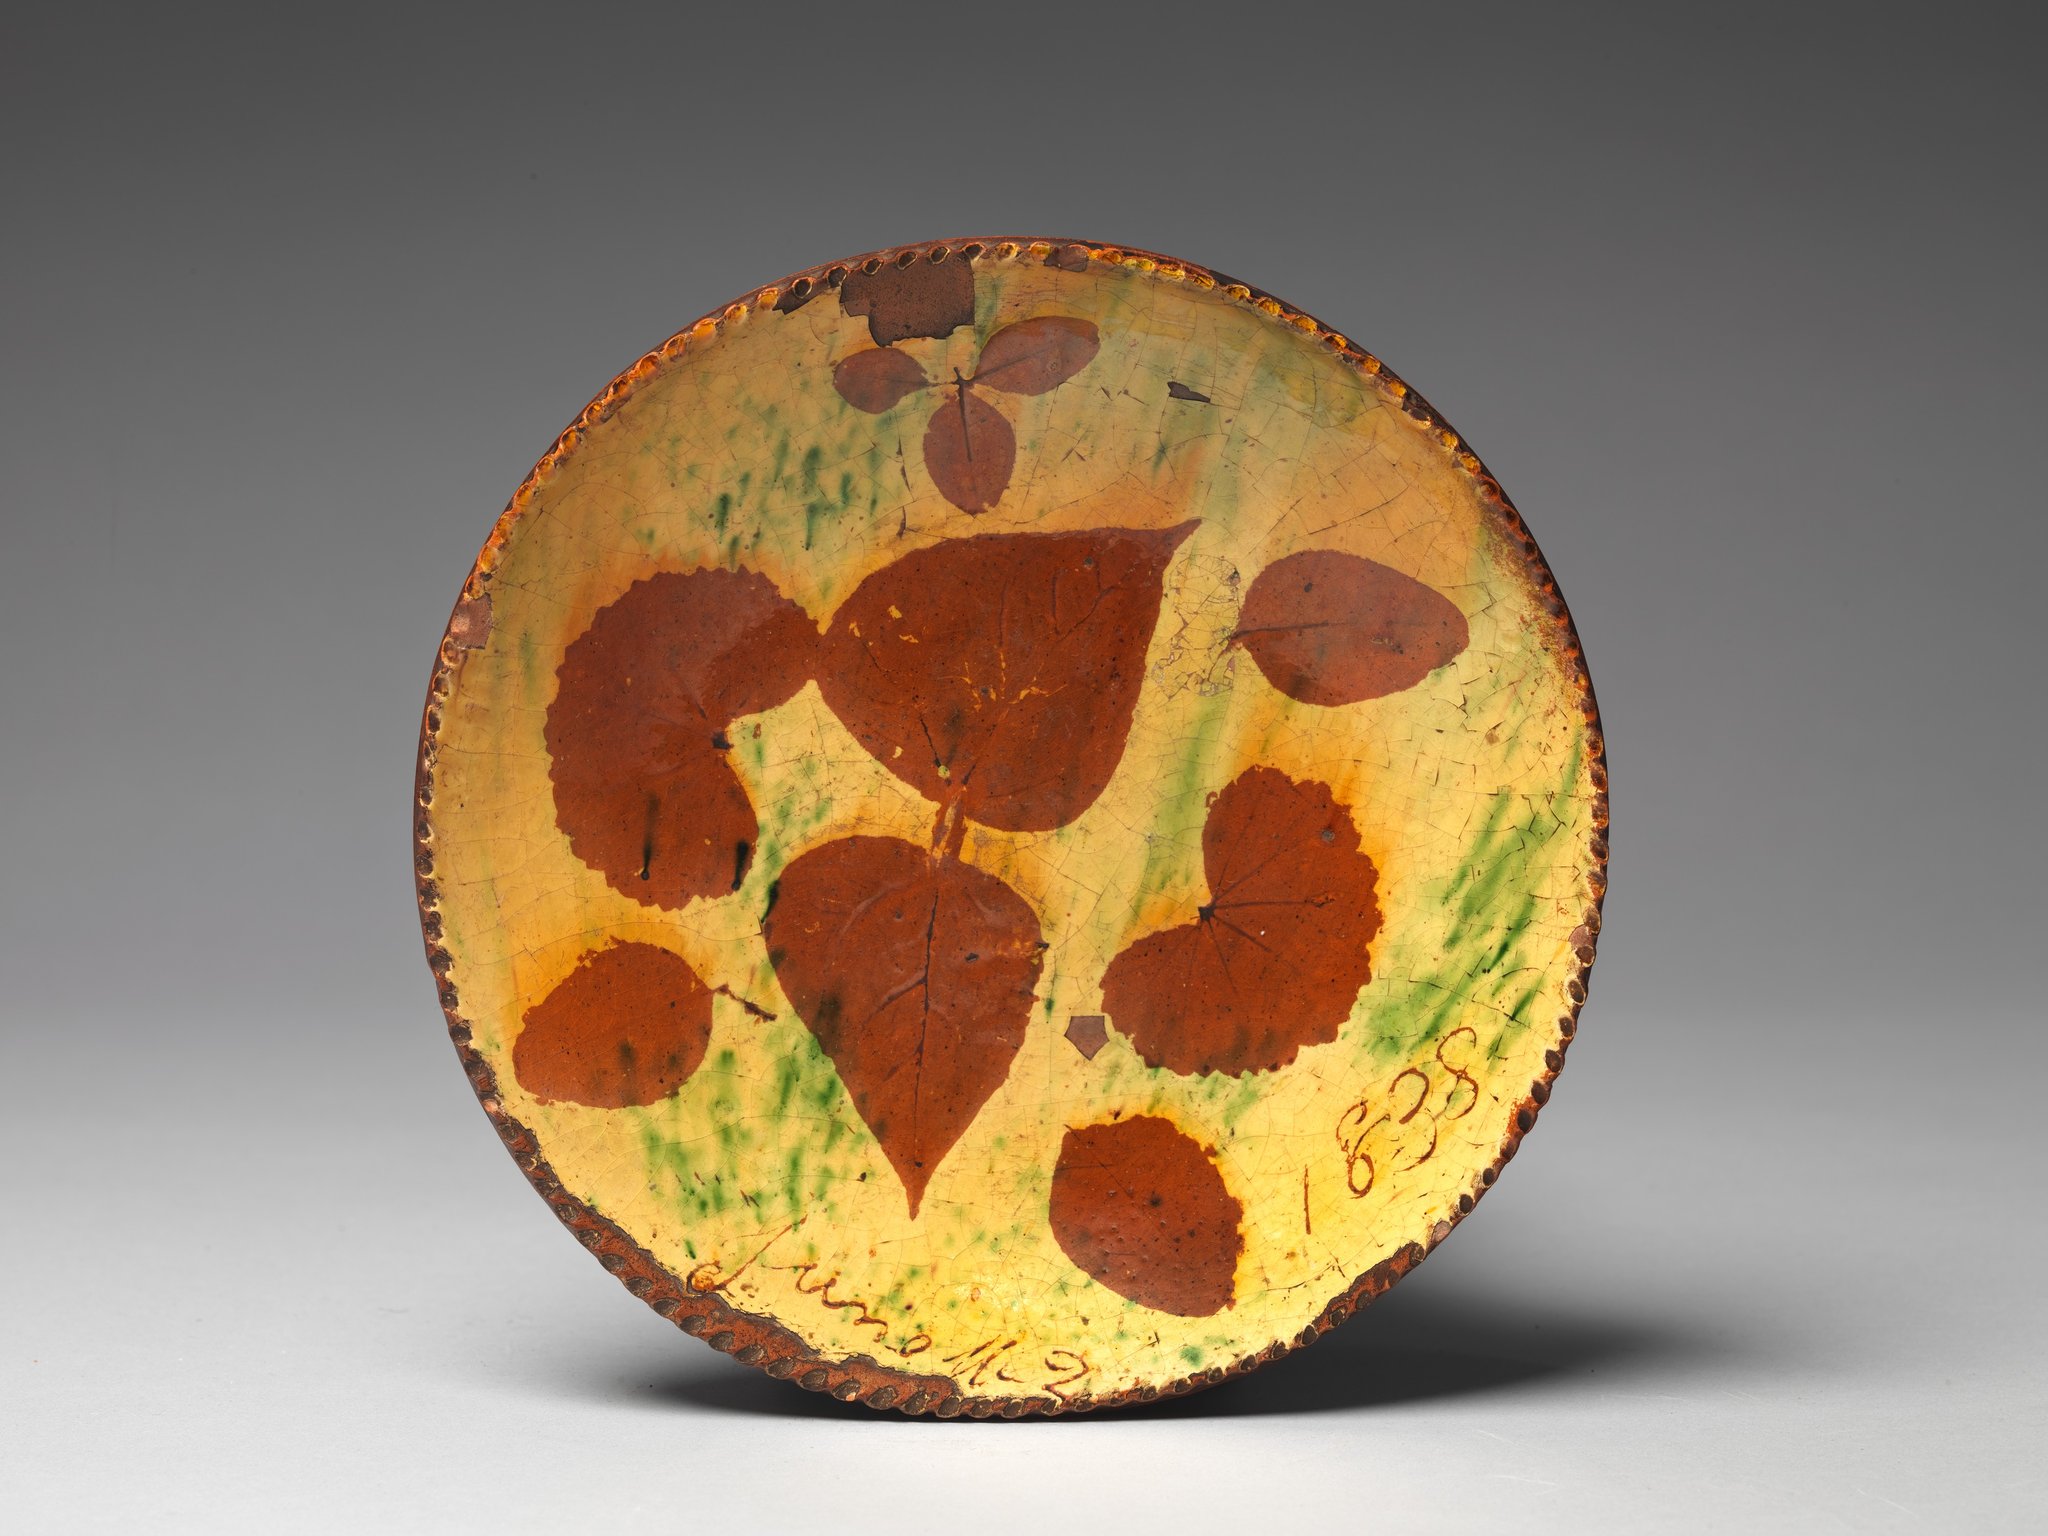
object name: plate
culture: american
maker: conrad ranninger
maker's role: maker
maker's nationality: american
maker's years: 1809-1869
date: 1838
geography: united states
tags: leaves